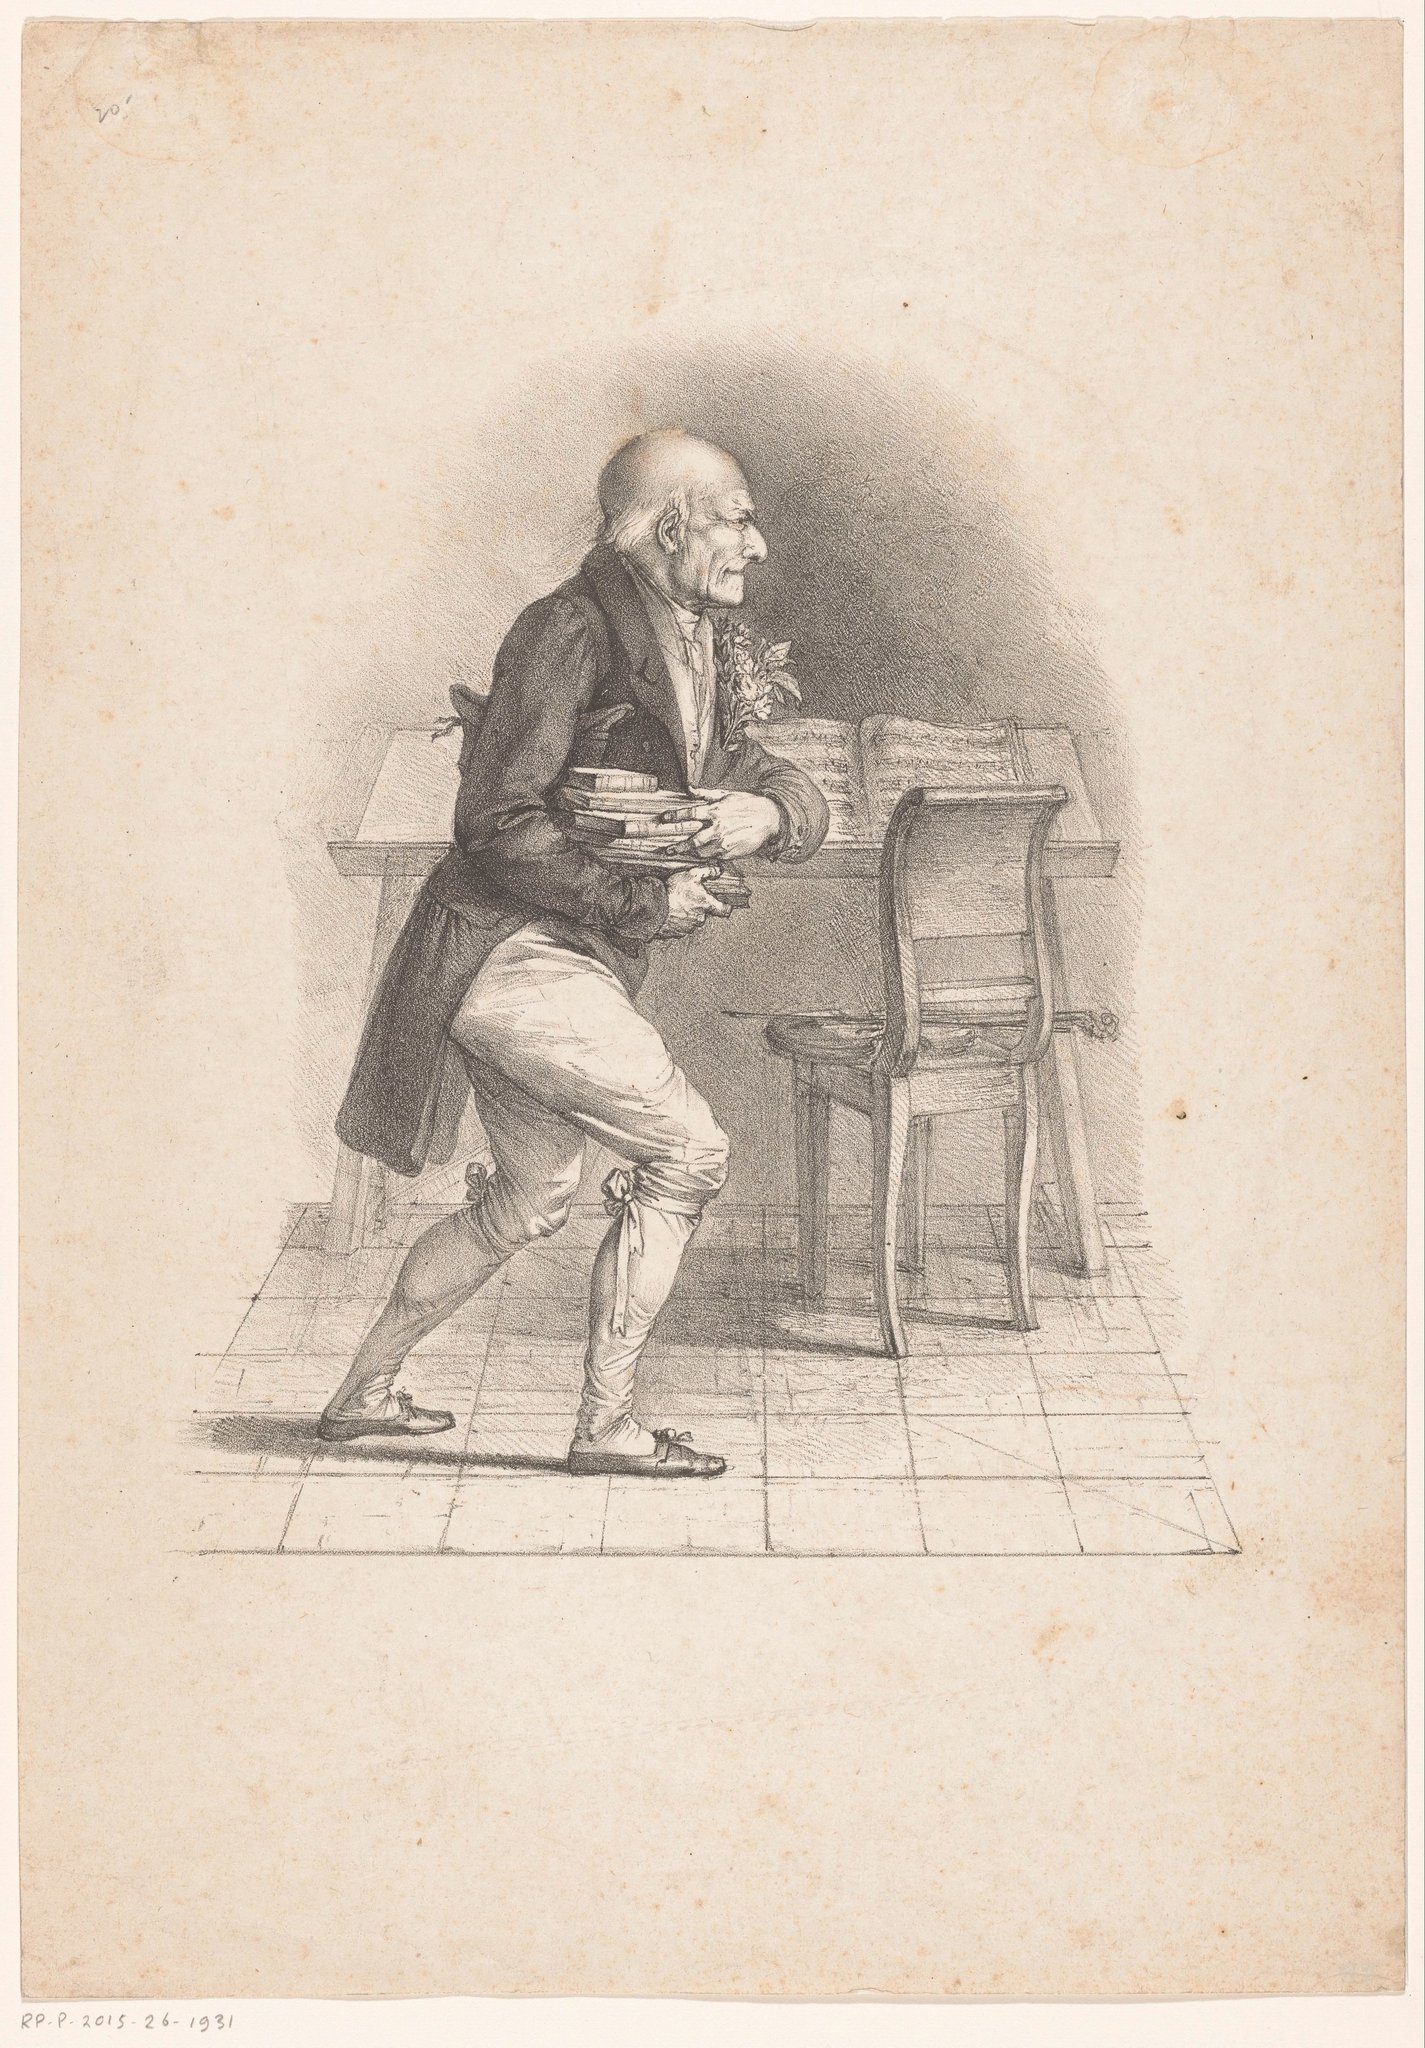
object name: print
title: Violist met een stapel boeken onder zijn arm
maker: Anonymous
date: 1800-1850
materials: paper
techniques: lithograph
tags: notation of music, violin, fiddle, book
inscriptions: collector's mark: Lugt 2228, collector's mark: Lugt 4780, collector's mark: Lugt 4779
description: Een man met een kaal hoofd en bloemen op zijn jas houdt onder zijn rechterarm een hoed en een stapel boeken. In de achtergrond staat een lessenaar met opengeslagen bladmuziek en een stoel met een viool.